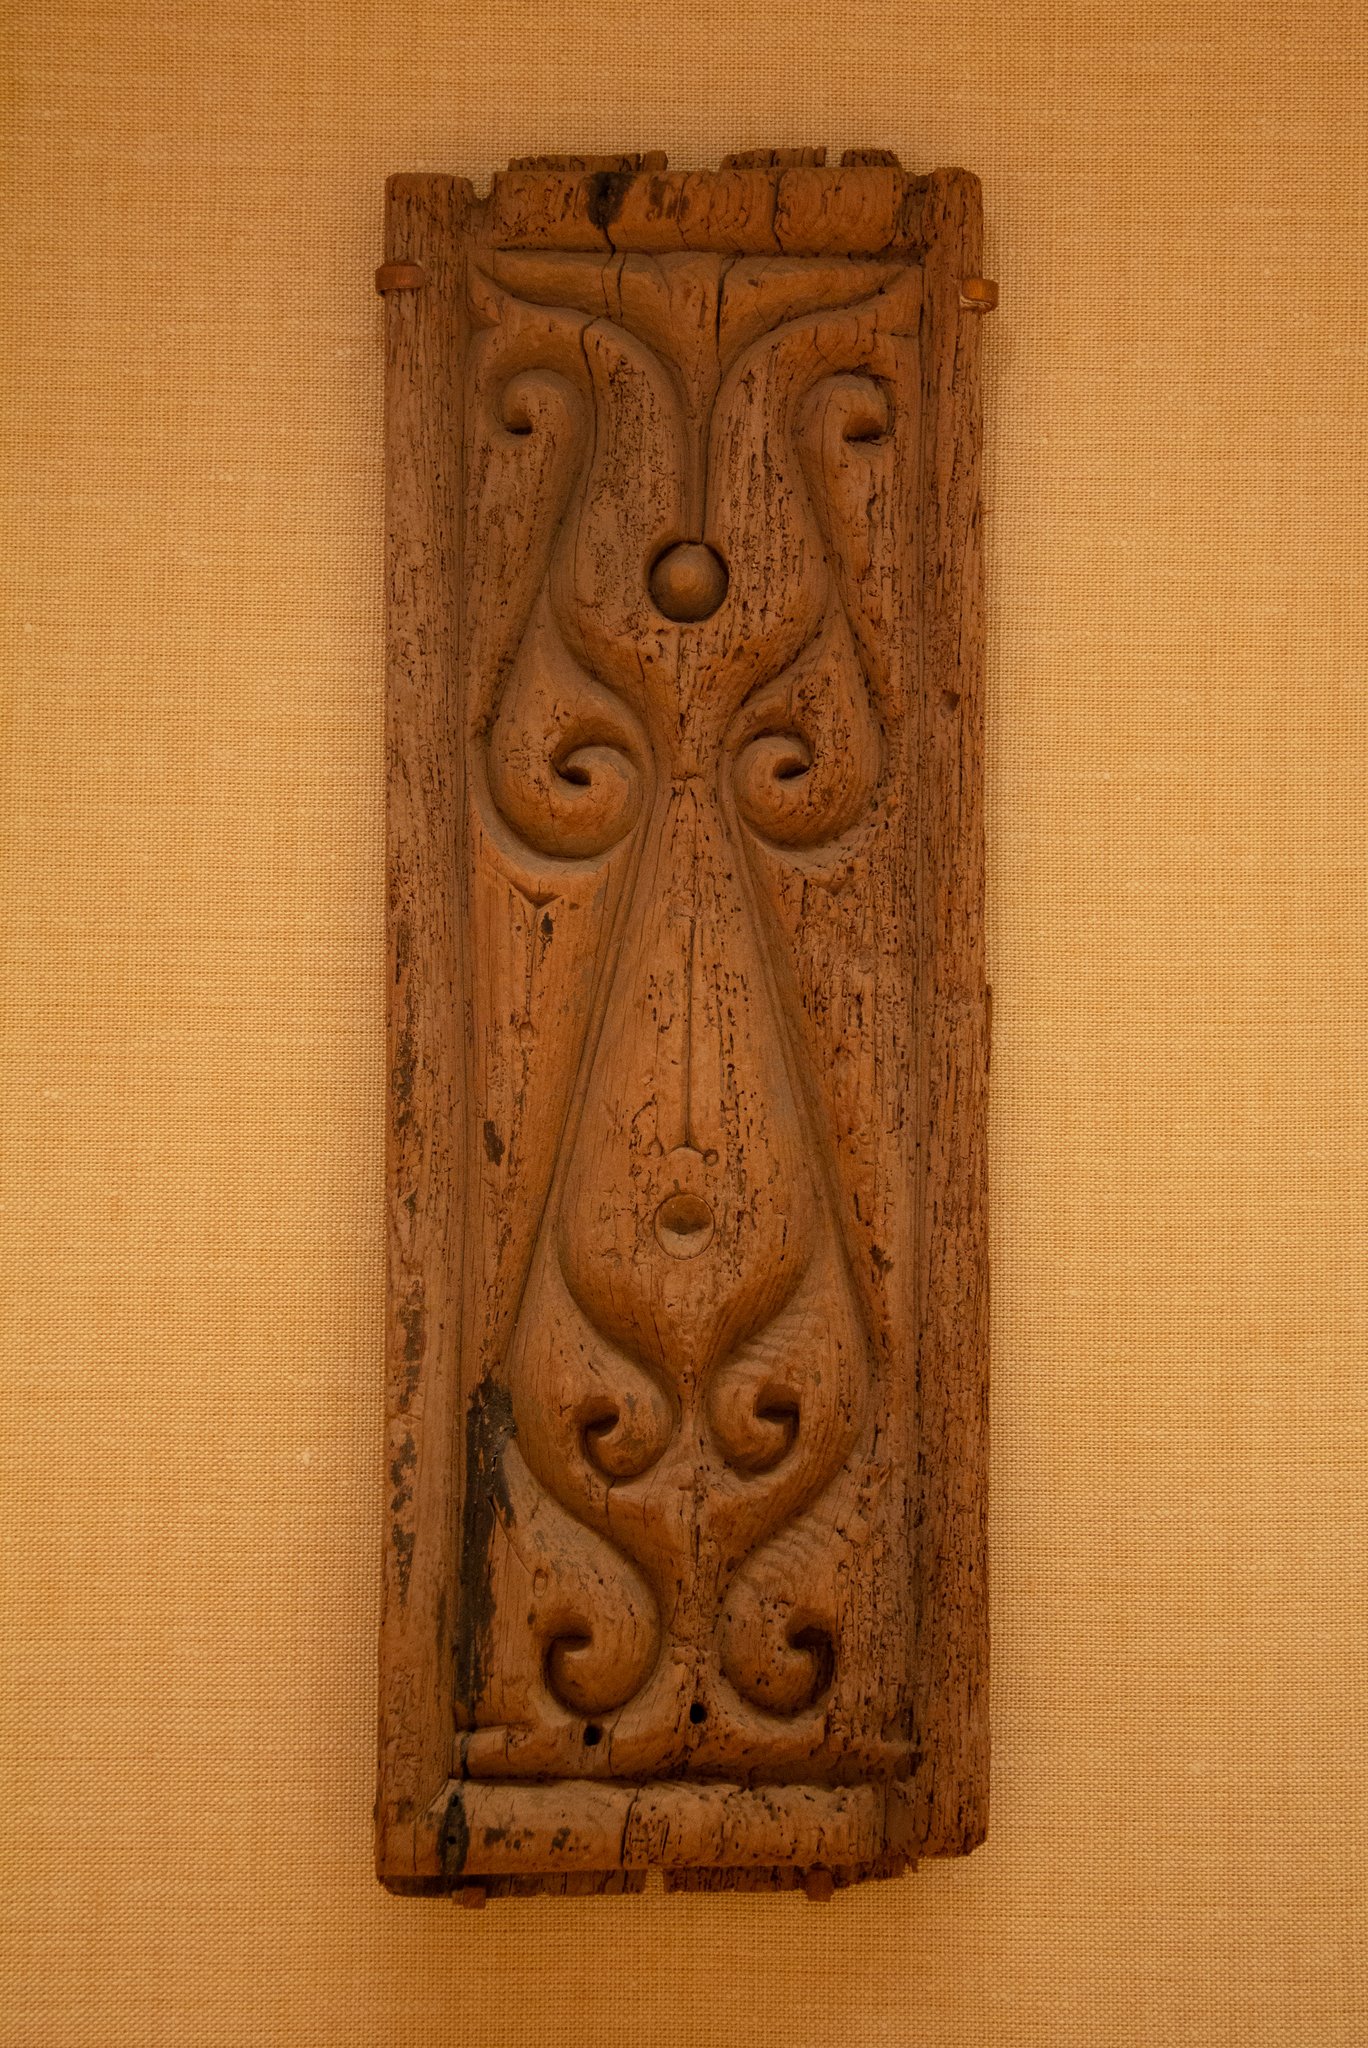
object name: door panel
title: Carved Architectural Panel in the 'Beveled Style'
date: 867-900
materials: wood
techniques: carving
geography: egypt